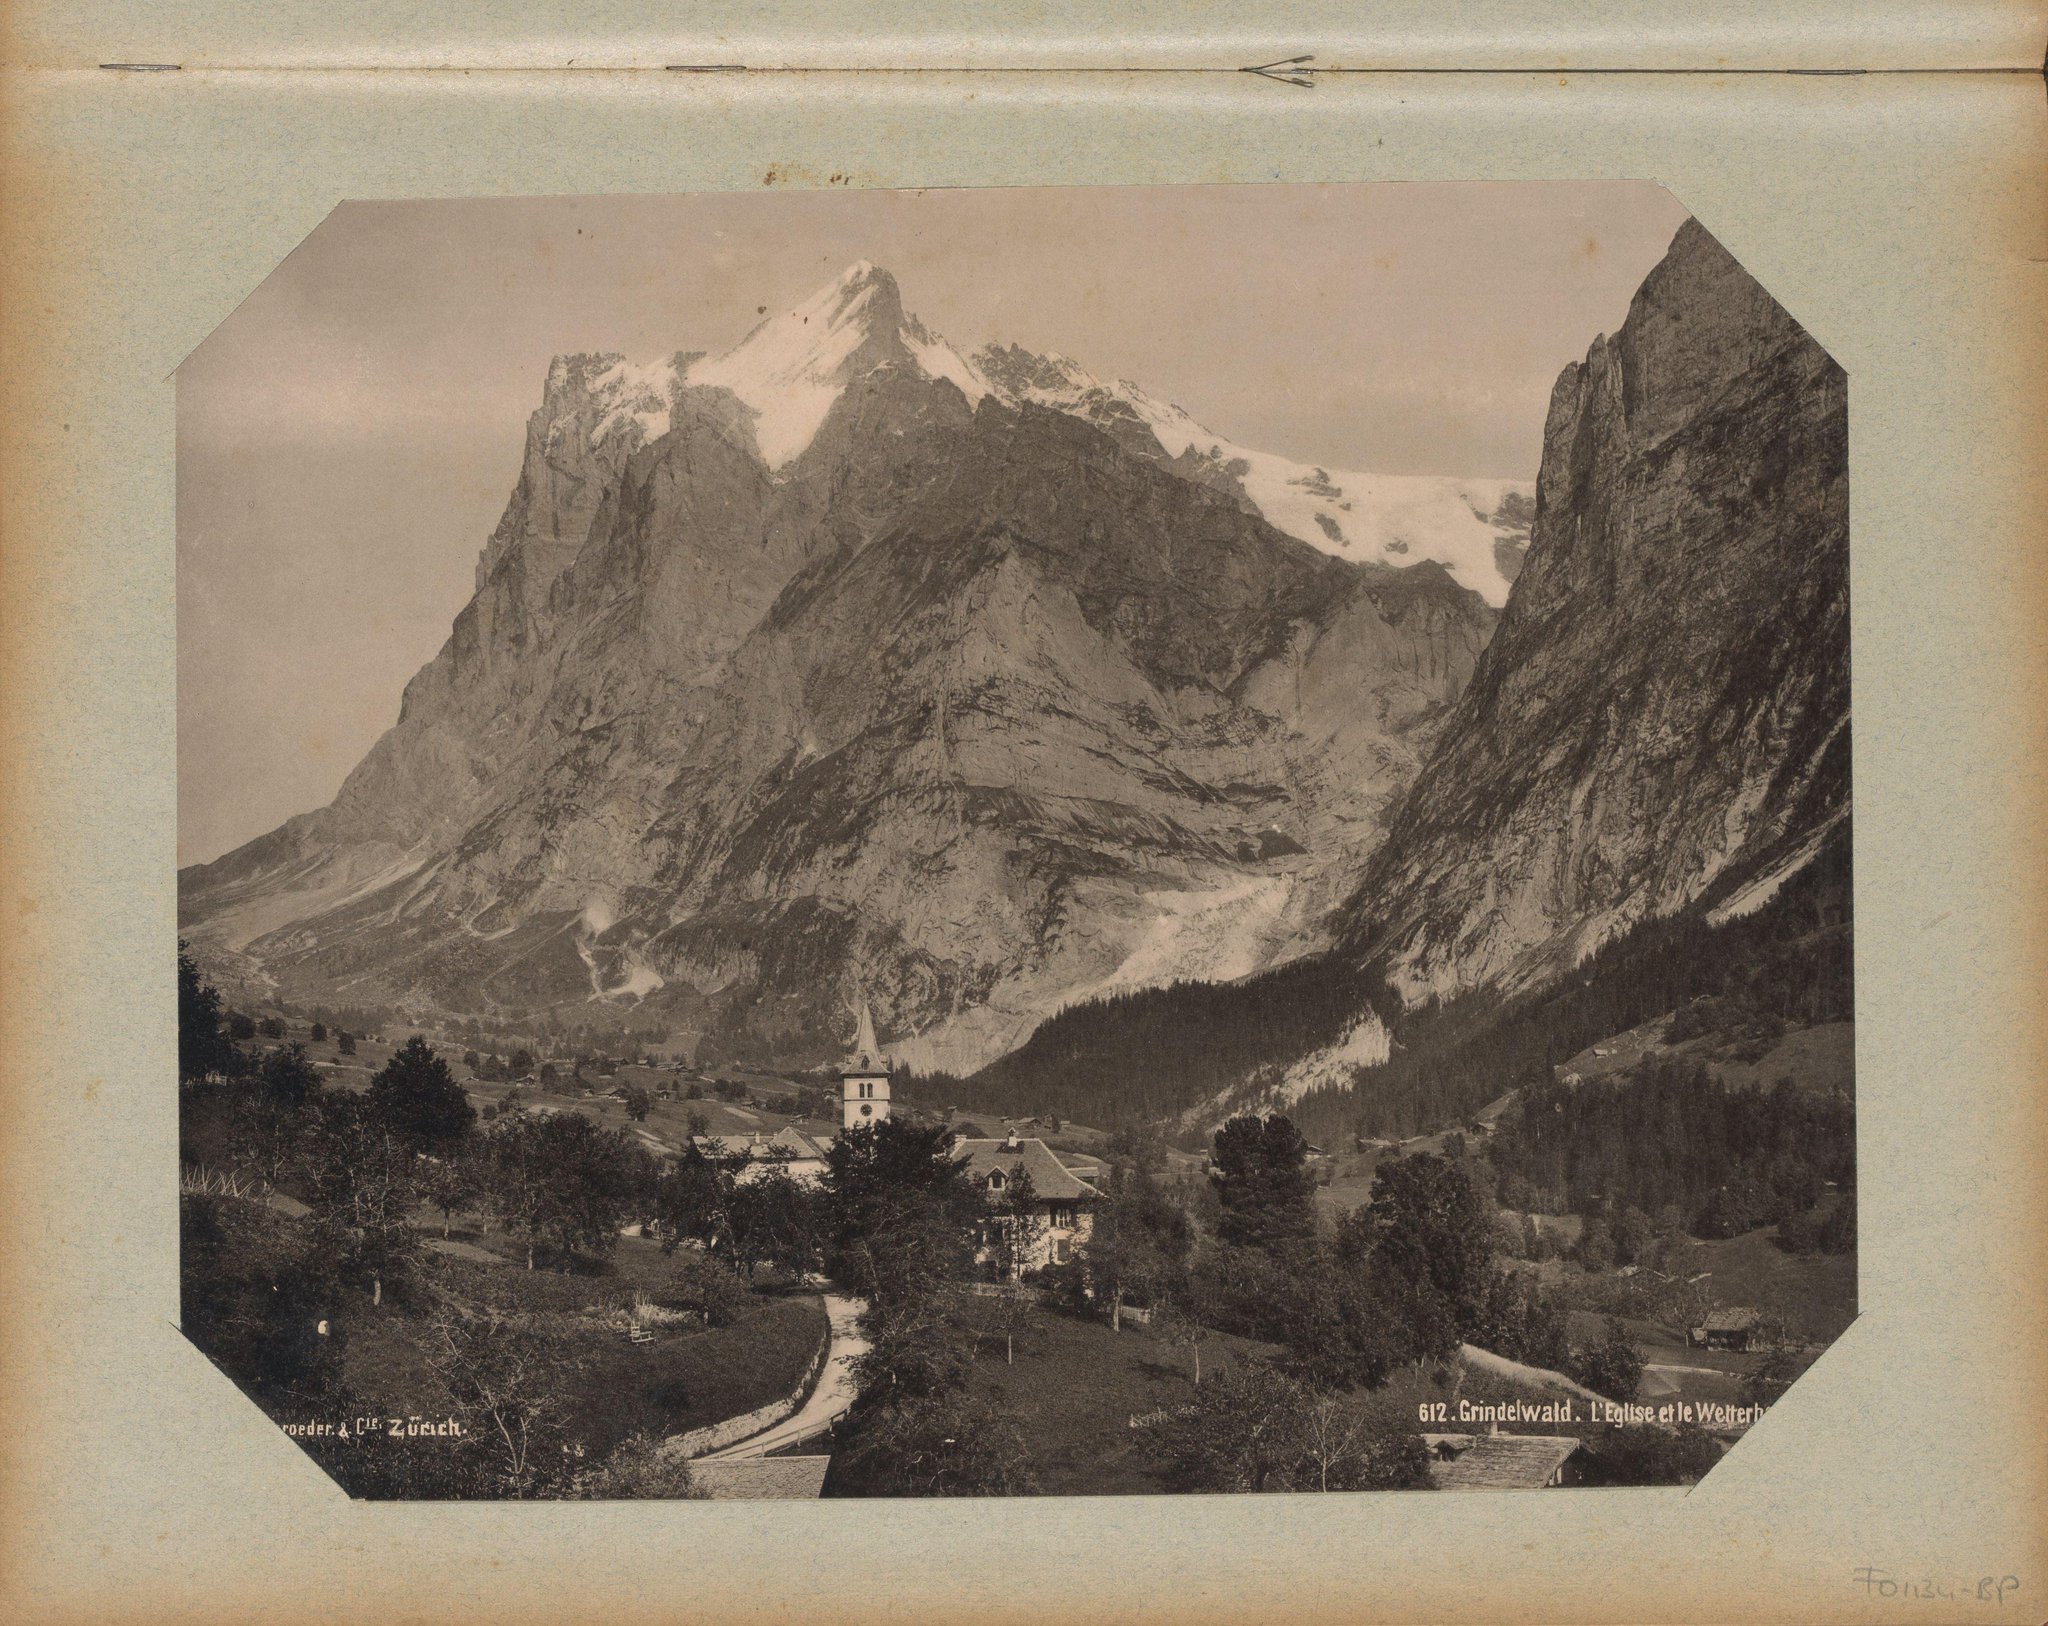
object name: photograph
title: Gezicht op Grindelwald met op de achtergrond de Wetterhorn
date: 1880-1910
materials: paper, ink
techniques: photograph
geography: grindelwald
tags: prospect of village, silhouette of village, mountain-range, snow peaks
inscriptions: number: ‘612’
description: Onderdeel van Reisalbum met bezienswaardigheden in Engeland, Zwitserland, Frankrijk en Duitsland.